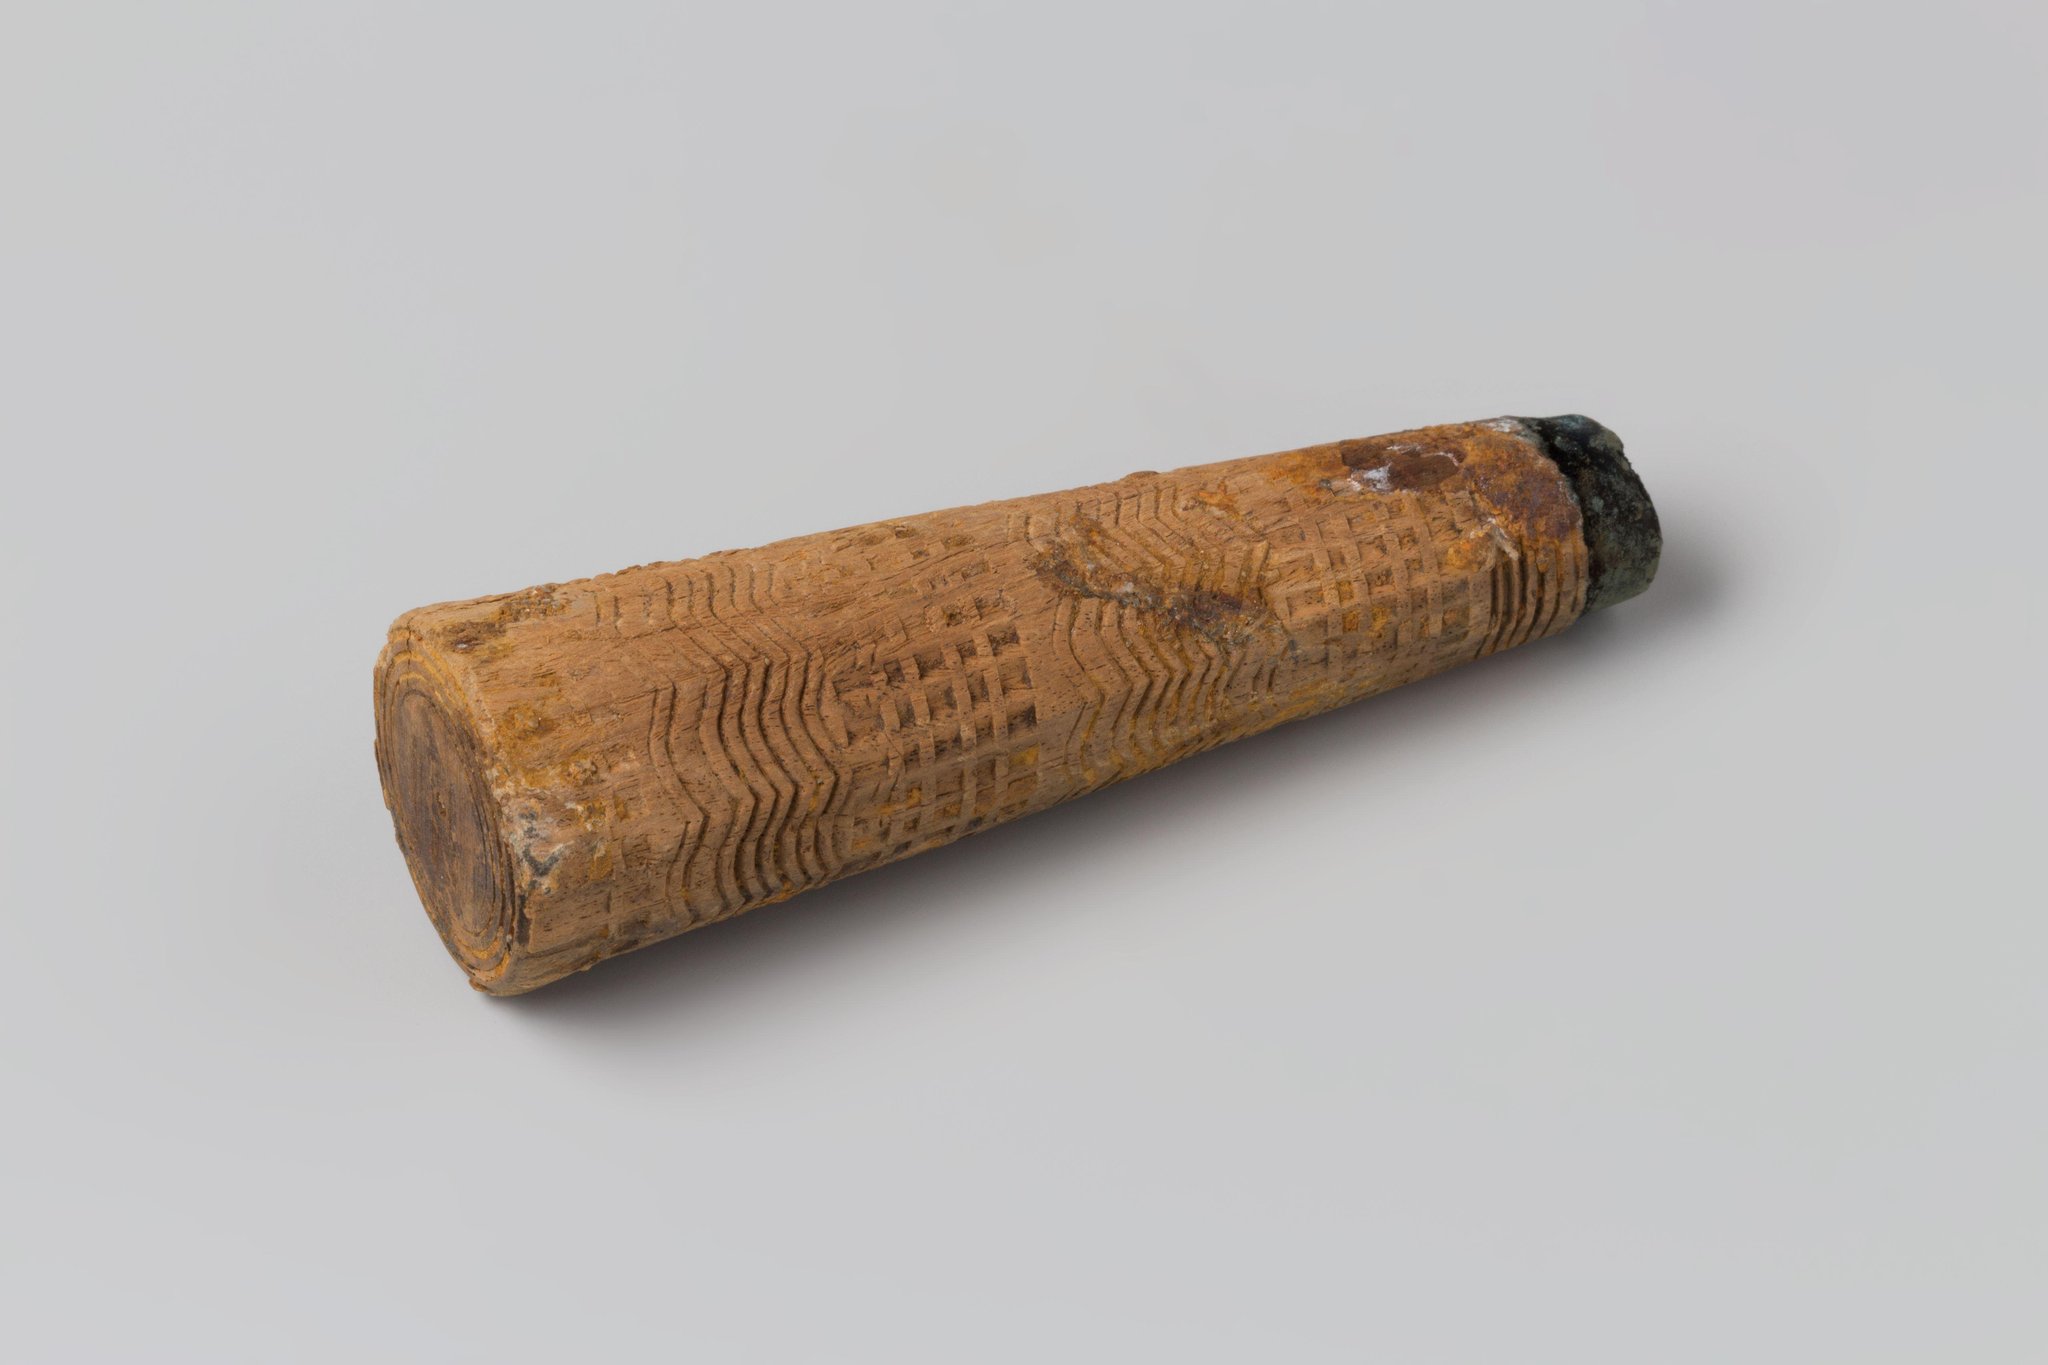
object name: knife handle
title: Messenheft uit het wrak van de Oost-Indiëvaarder Hollandia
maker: Anonymous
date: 1700-1743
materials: wood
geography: netherlands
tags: verenigde oostindische compagnie, hollandia (schip), annet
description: Knife, handle, cylindrical: tapering; id. NG 1979-403H, ferrules, id. NG 1980-27H426.